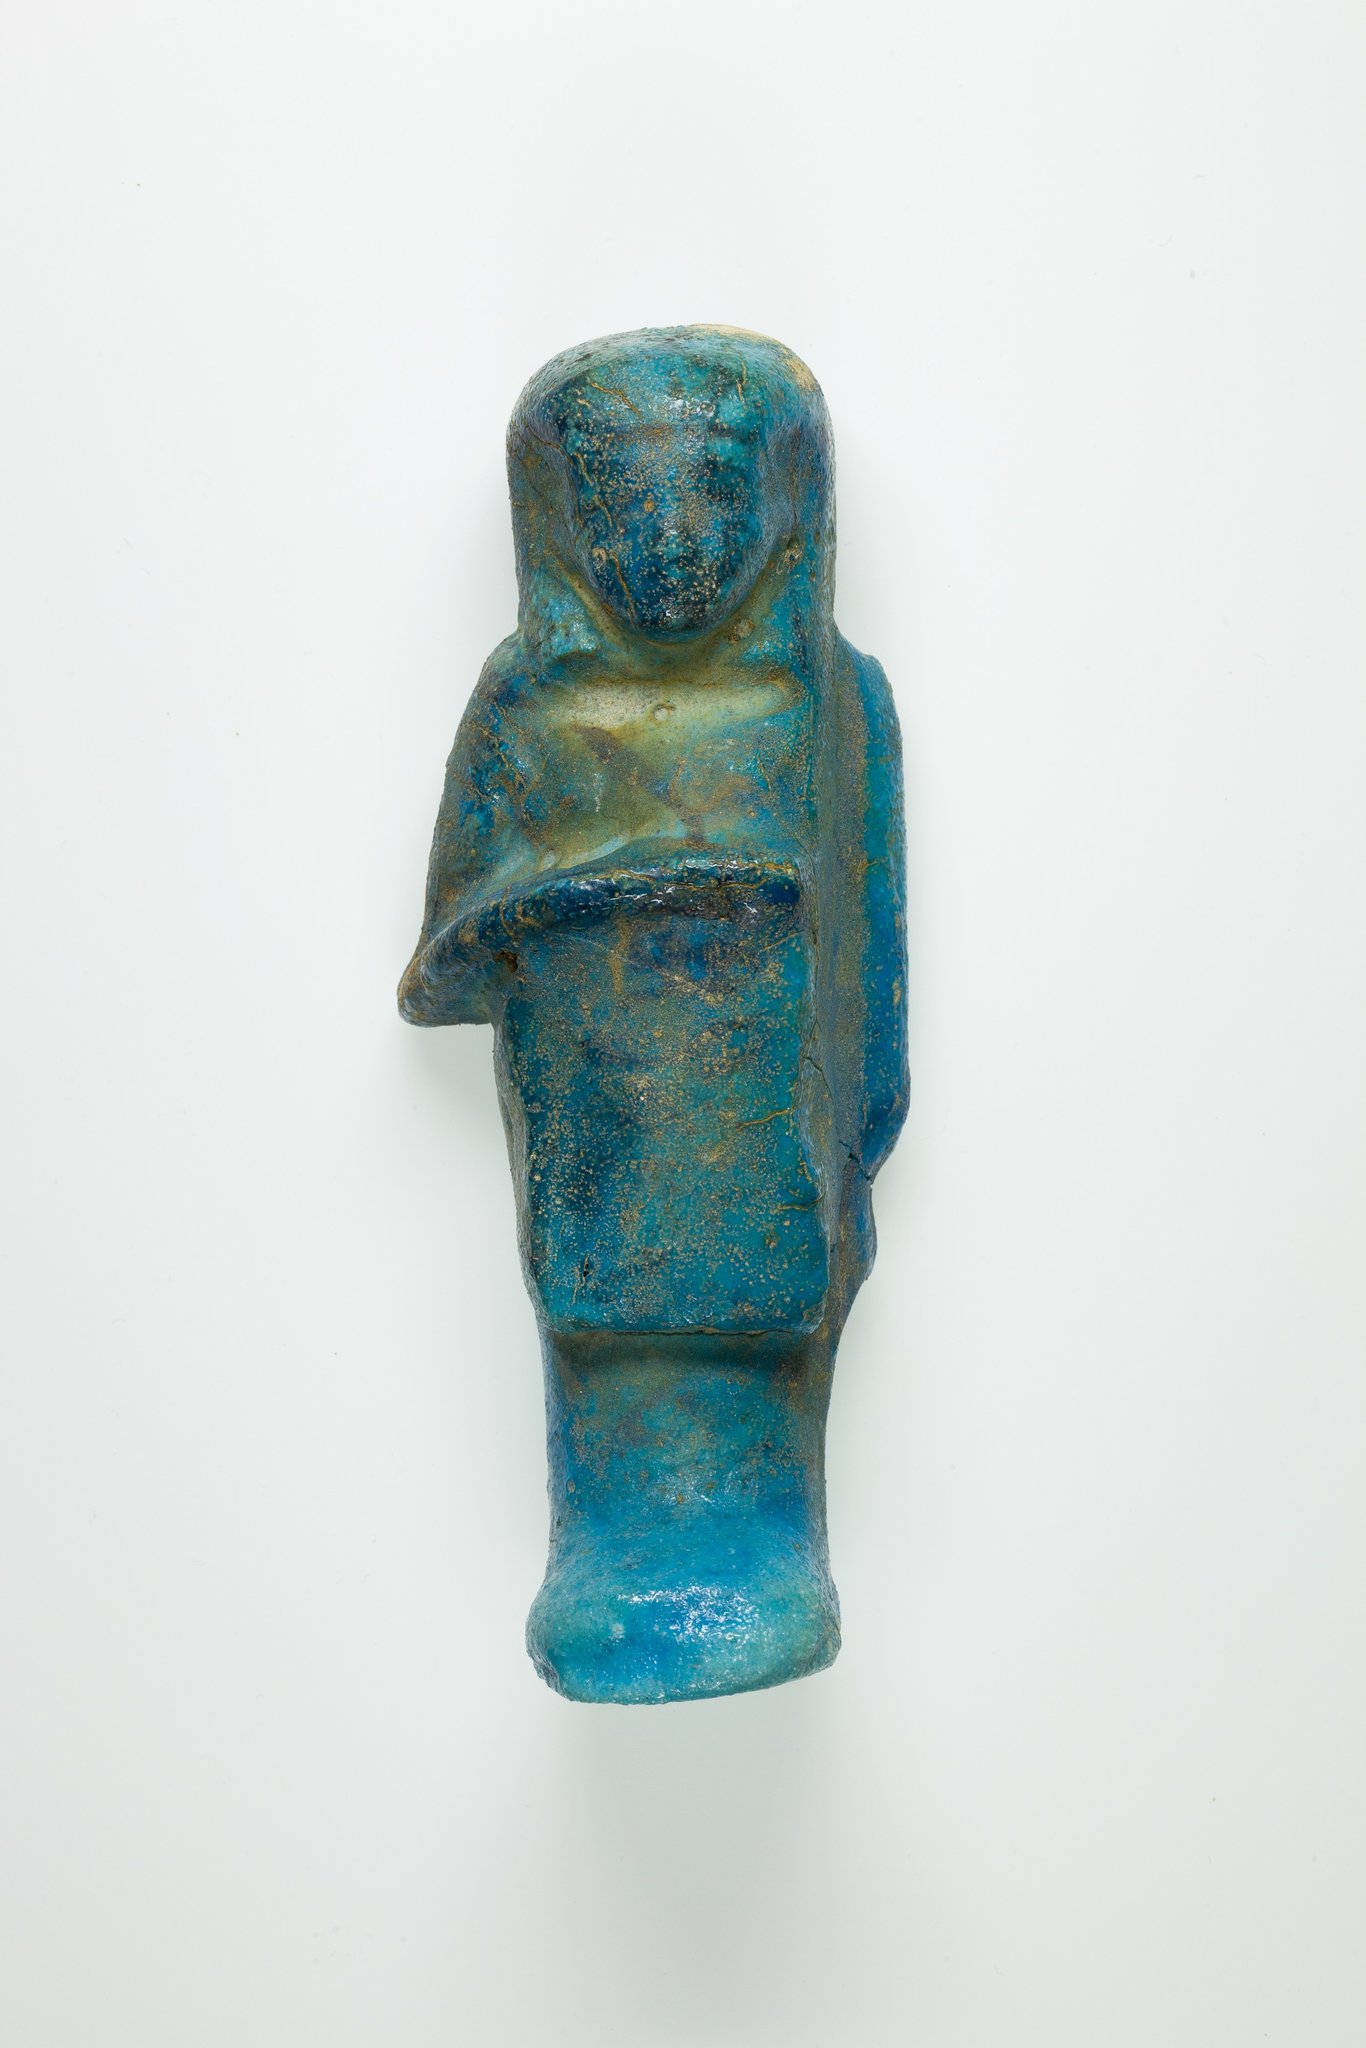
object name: overseer shabti, henettawy c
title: Overseer Shabti of Henettawy (C), Daughter of Isetemkheb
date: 990-970 BCE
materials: faience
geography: egypt